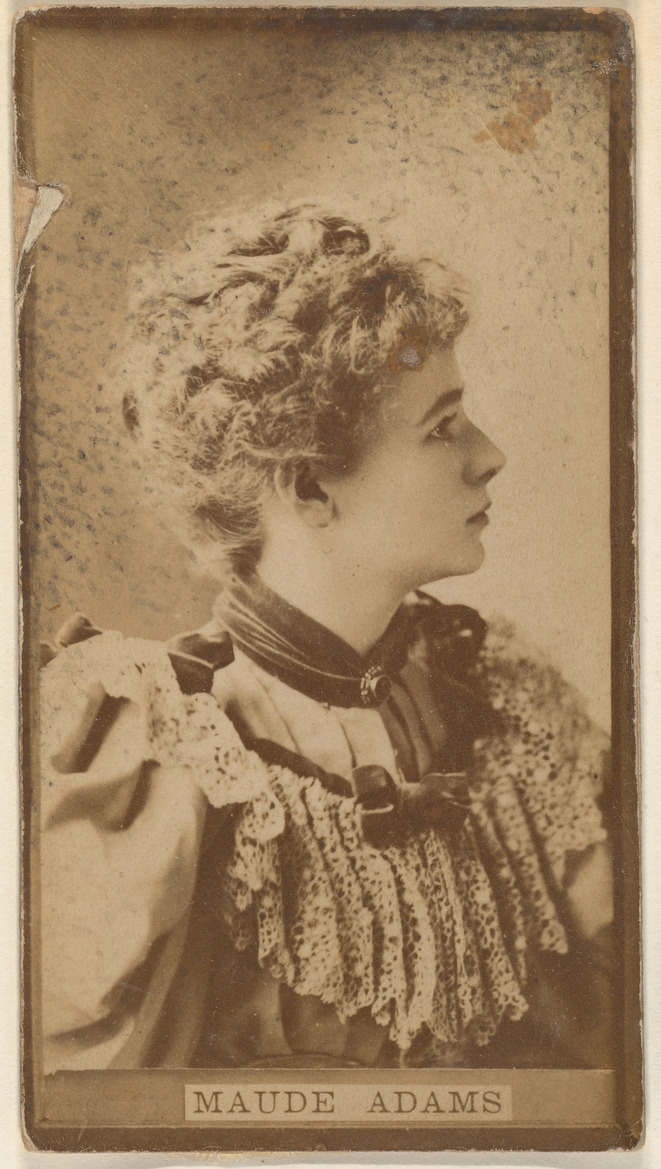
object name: photograph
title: Maude Adams, from the Actresses series (N668)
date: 1888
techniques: albumen silver print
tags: portraits,profiles,women,actresses